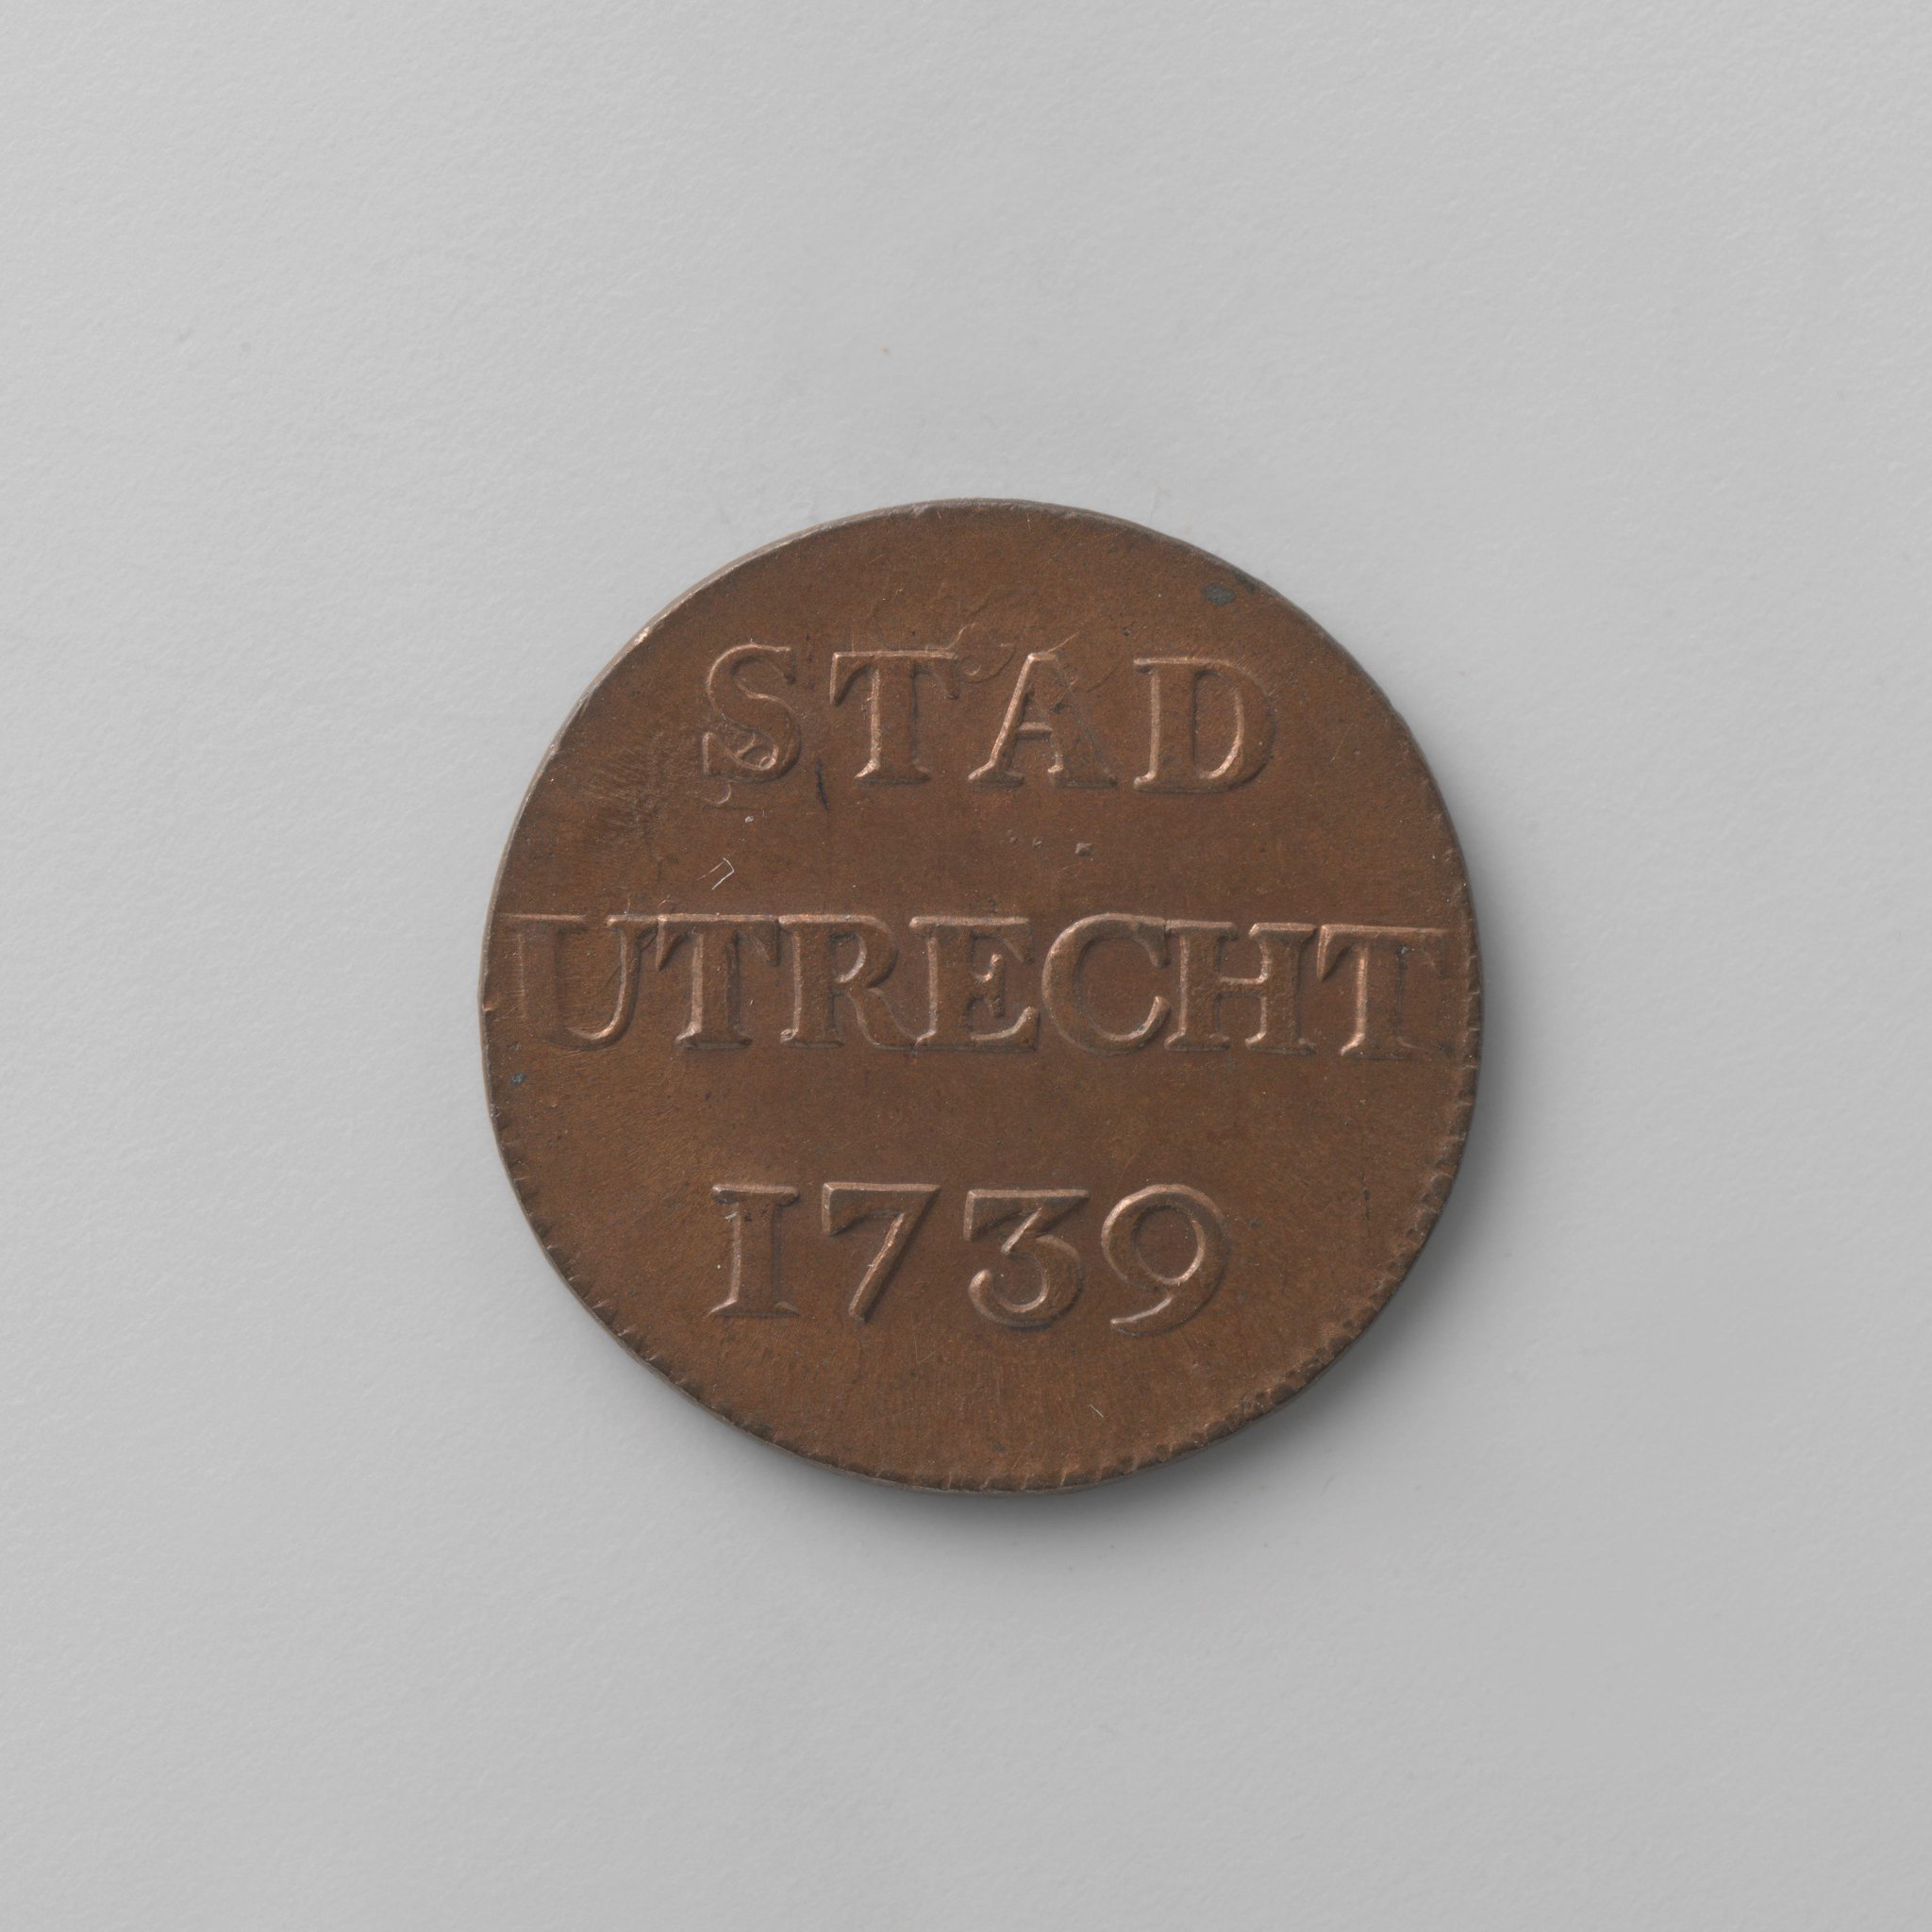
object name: coin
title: Stad Utrecht, duit, 1739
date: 1739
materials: copper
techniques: striking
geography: utrecht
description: Koperen munt. Voorzijde: gekroond stedelijk wapenschild, gehouden door twee leeuwen met in afsnede dunne lijn, waaronder een versierde accolade met een grote schelp. Keerzijde: opschrift in twee regels, waaronder jaartal. Jaartal met Romeinse I.